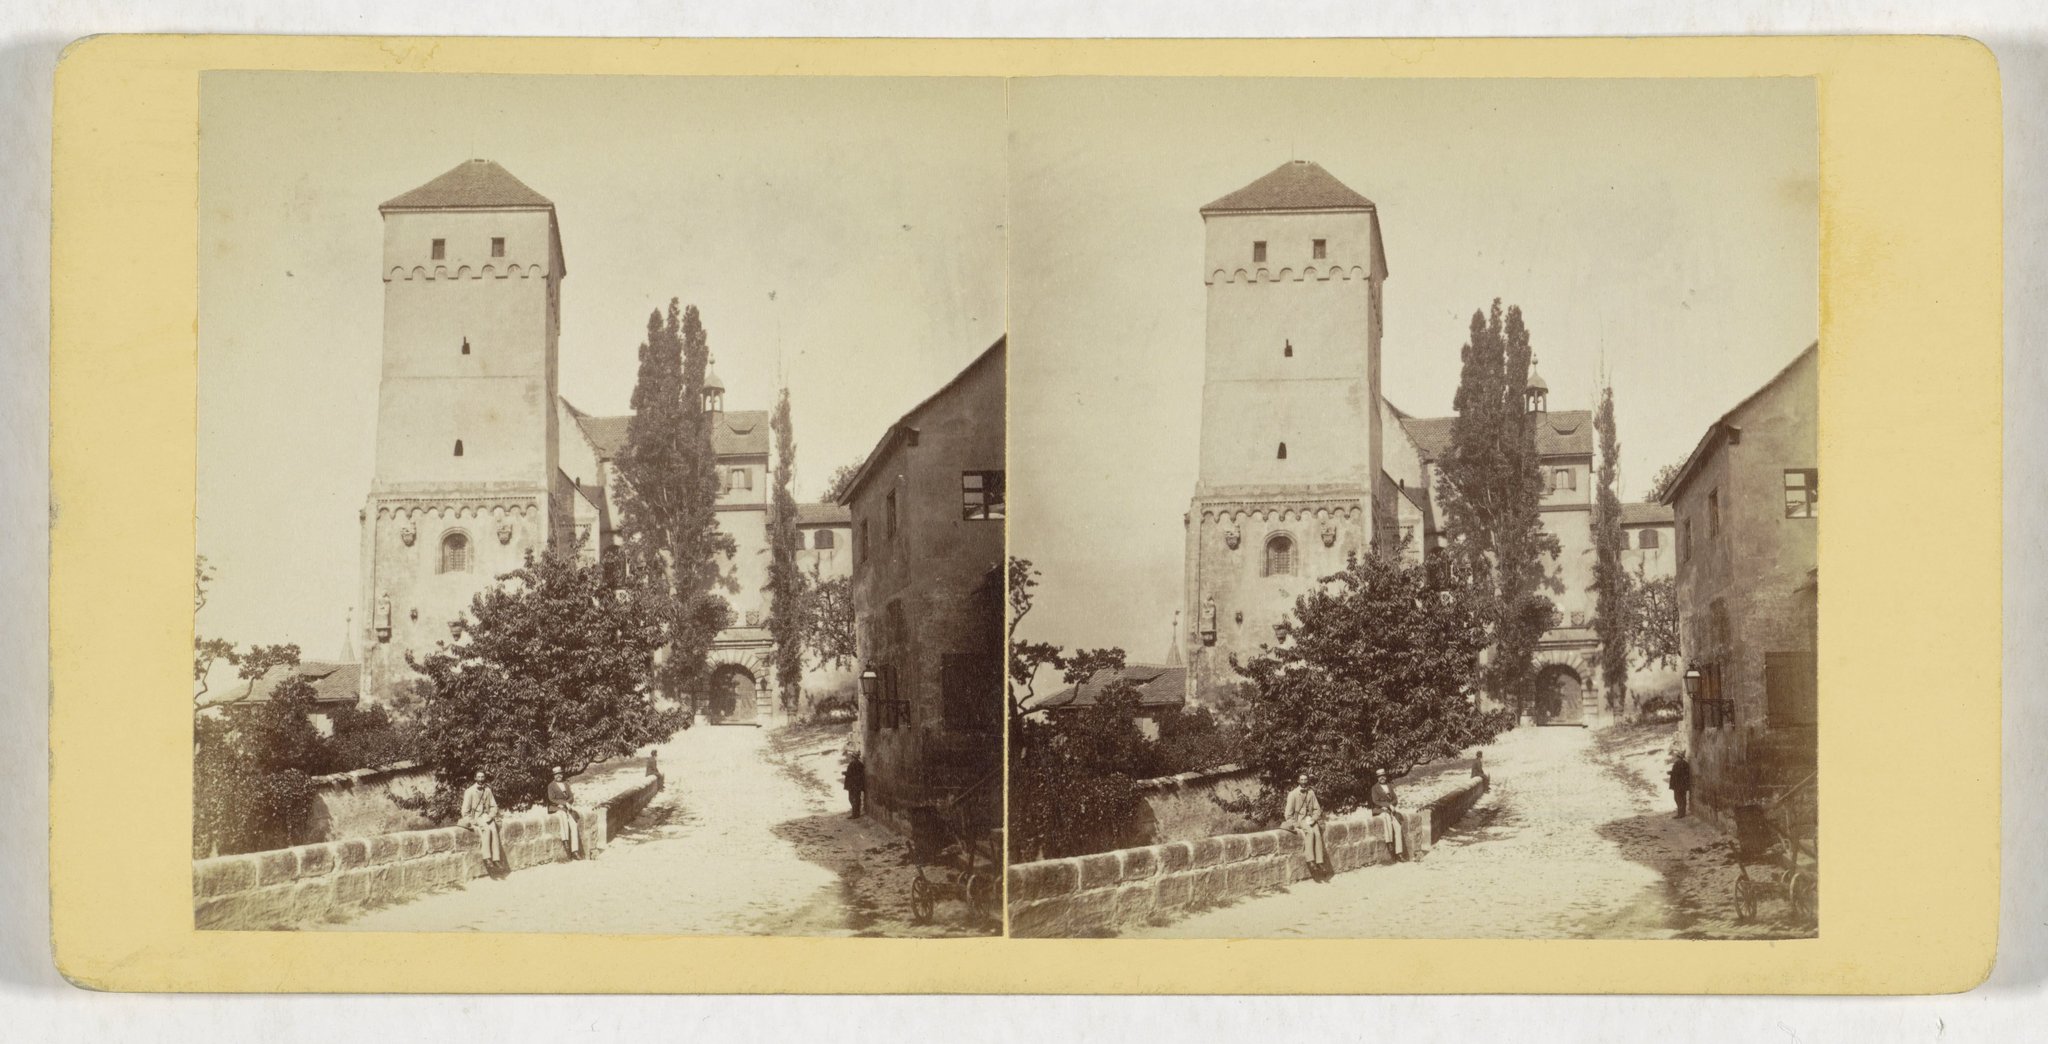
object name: stereograph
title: Deutschland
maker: johann friedrich stiehm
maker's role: fotograaf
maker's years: 1826-1902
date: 1868-1888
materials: cardboard, paper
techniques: albumen print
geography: nuremberg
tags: tower (of house or building)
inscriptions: number: ‘No. 18.’